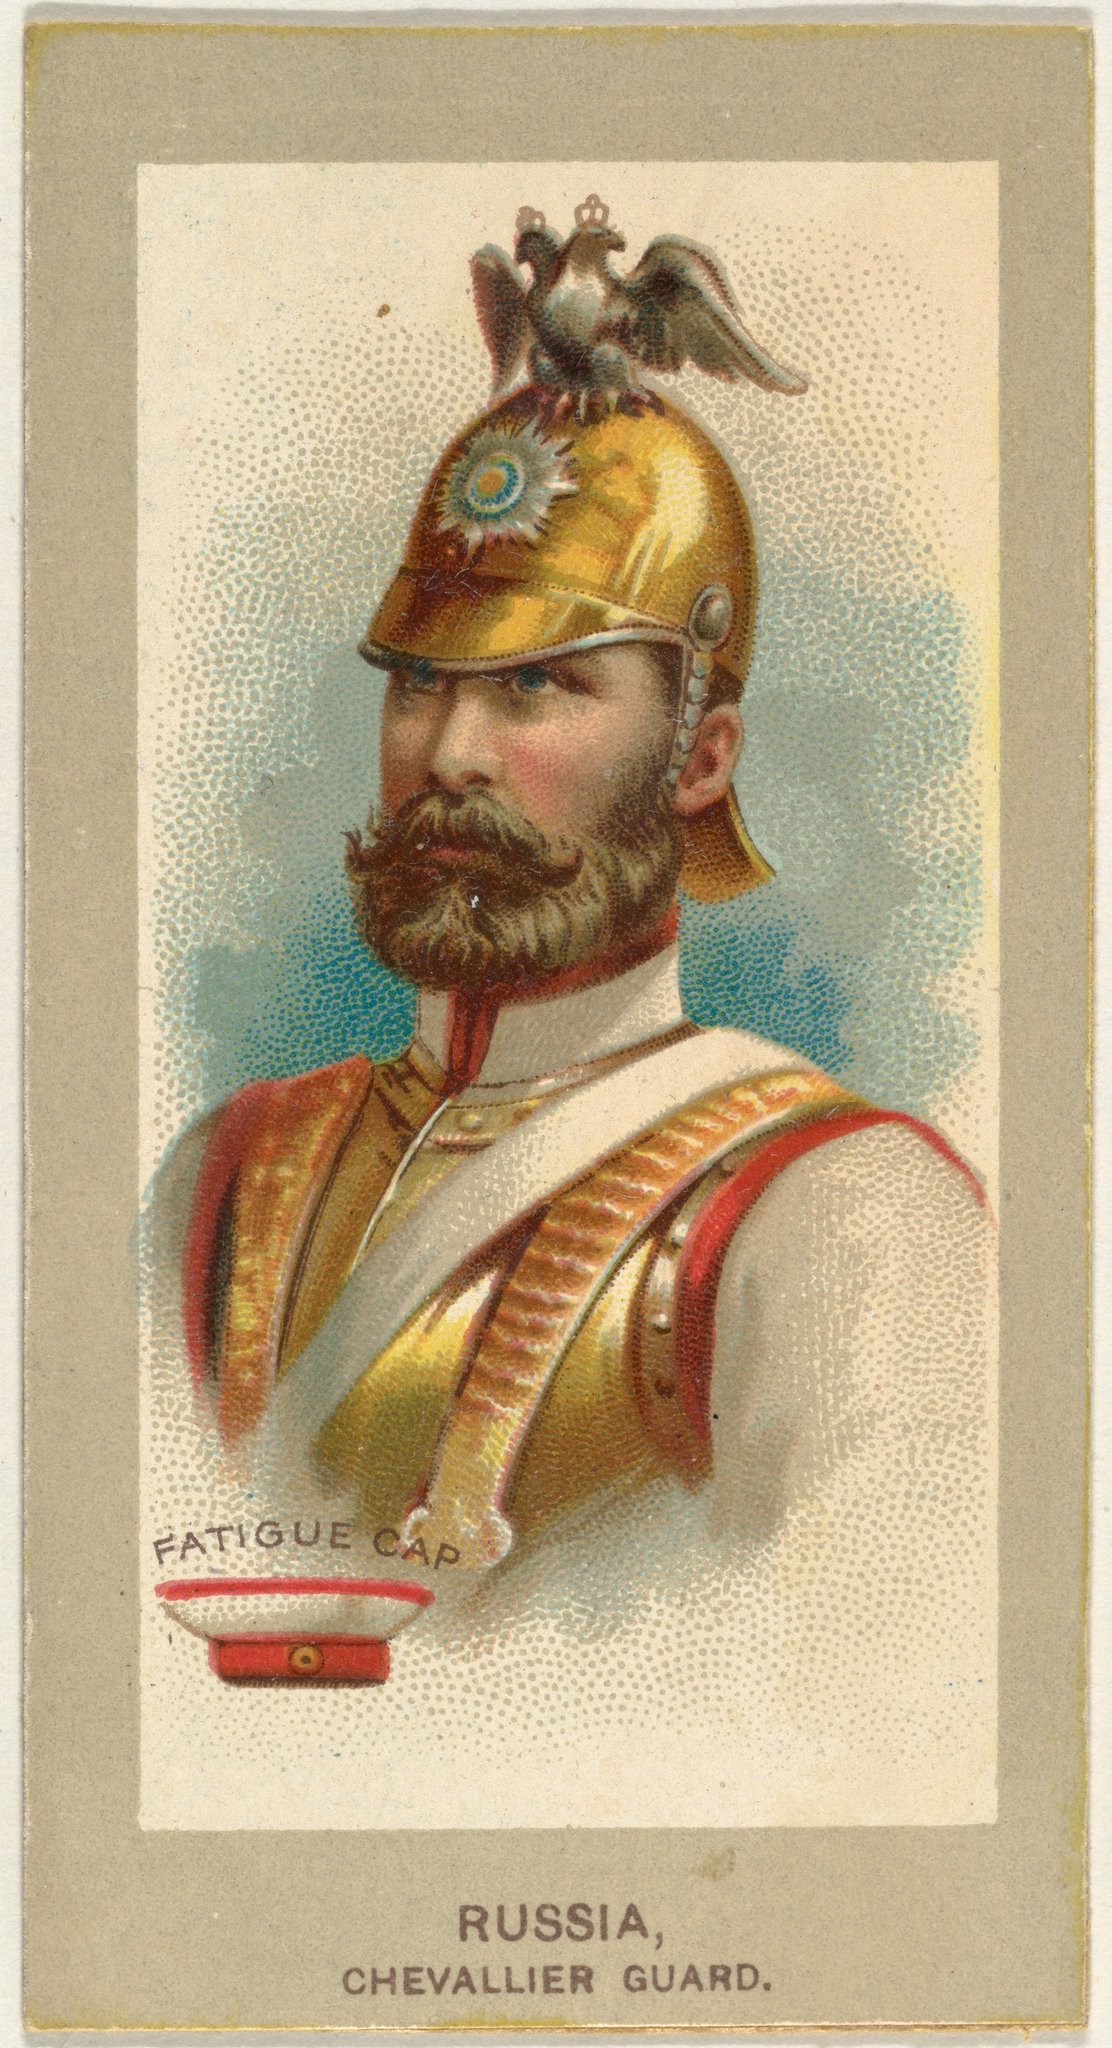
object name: print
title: Fatigue Cap, Chevallier Guard, Russia, from the Military Uniforms series (T182) issued by Abdul Cigarettes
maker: abdul cigarettes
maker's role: publisher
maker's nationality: american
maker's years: 1881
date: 1881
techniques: color lithograph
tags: men